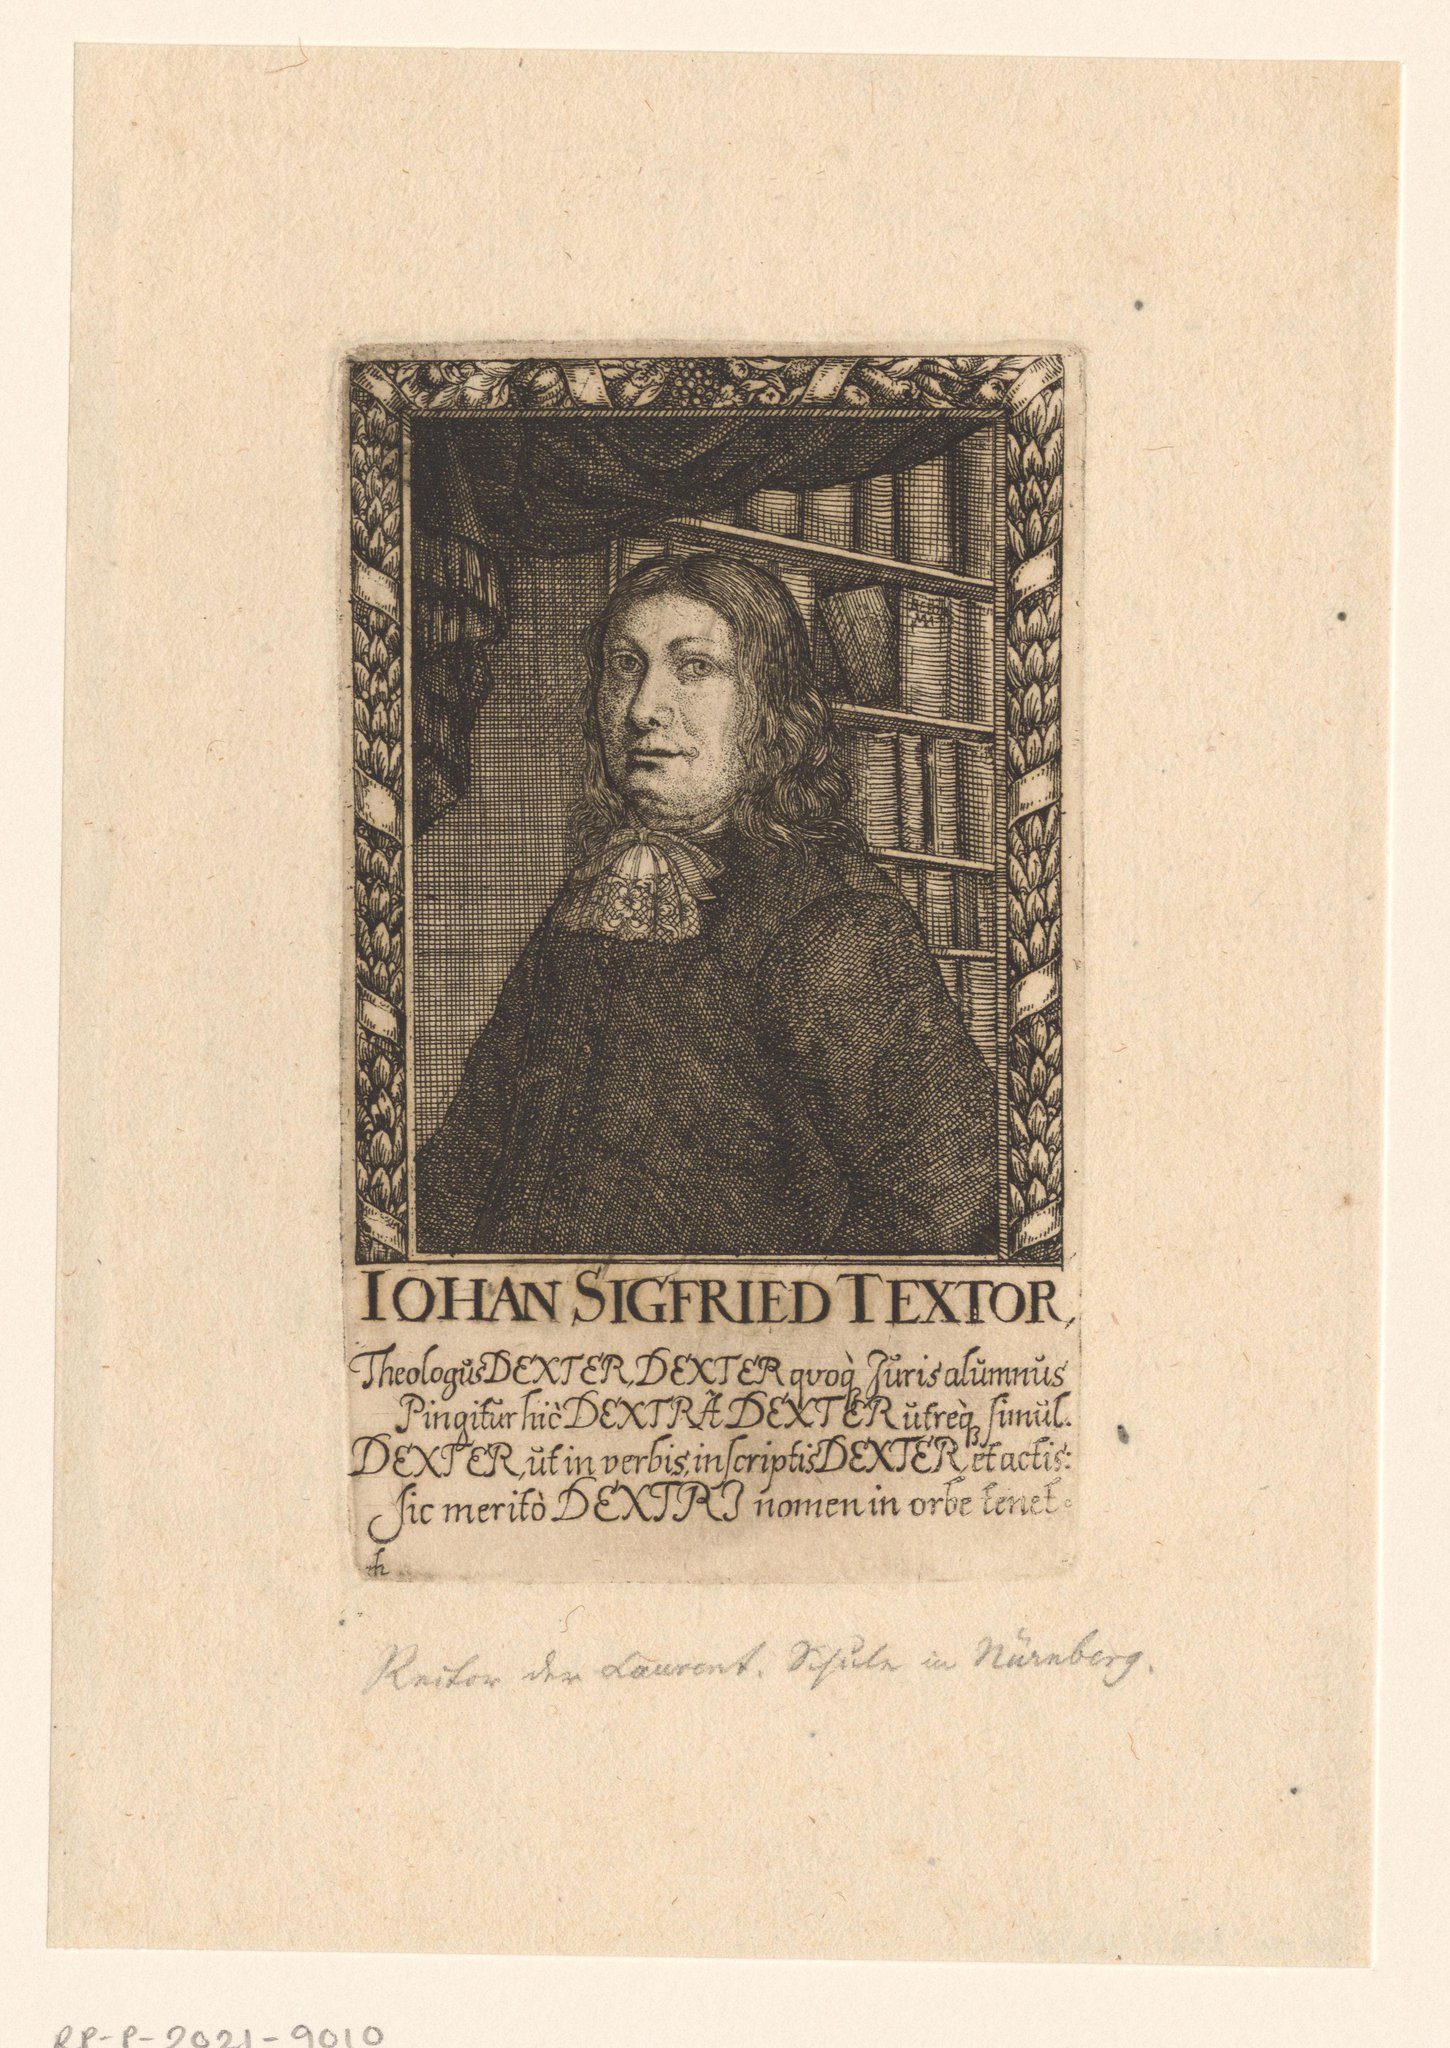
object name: print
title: Portret van Johann Siegfried Textor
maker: johann reinhold mühl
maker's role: print maker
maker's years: 1631-1692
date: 1641-1692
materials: paper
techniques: etching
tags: bookshelves, historical persons